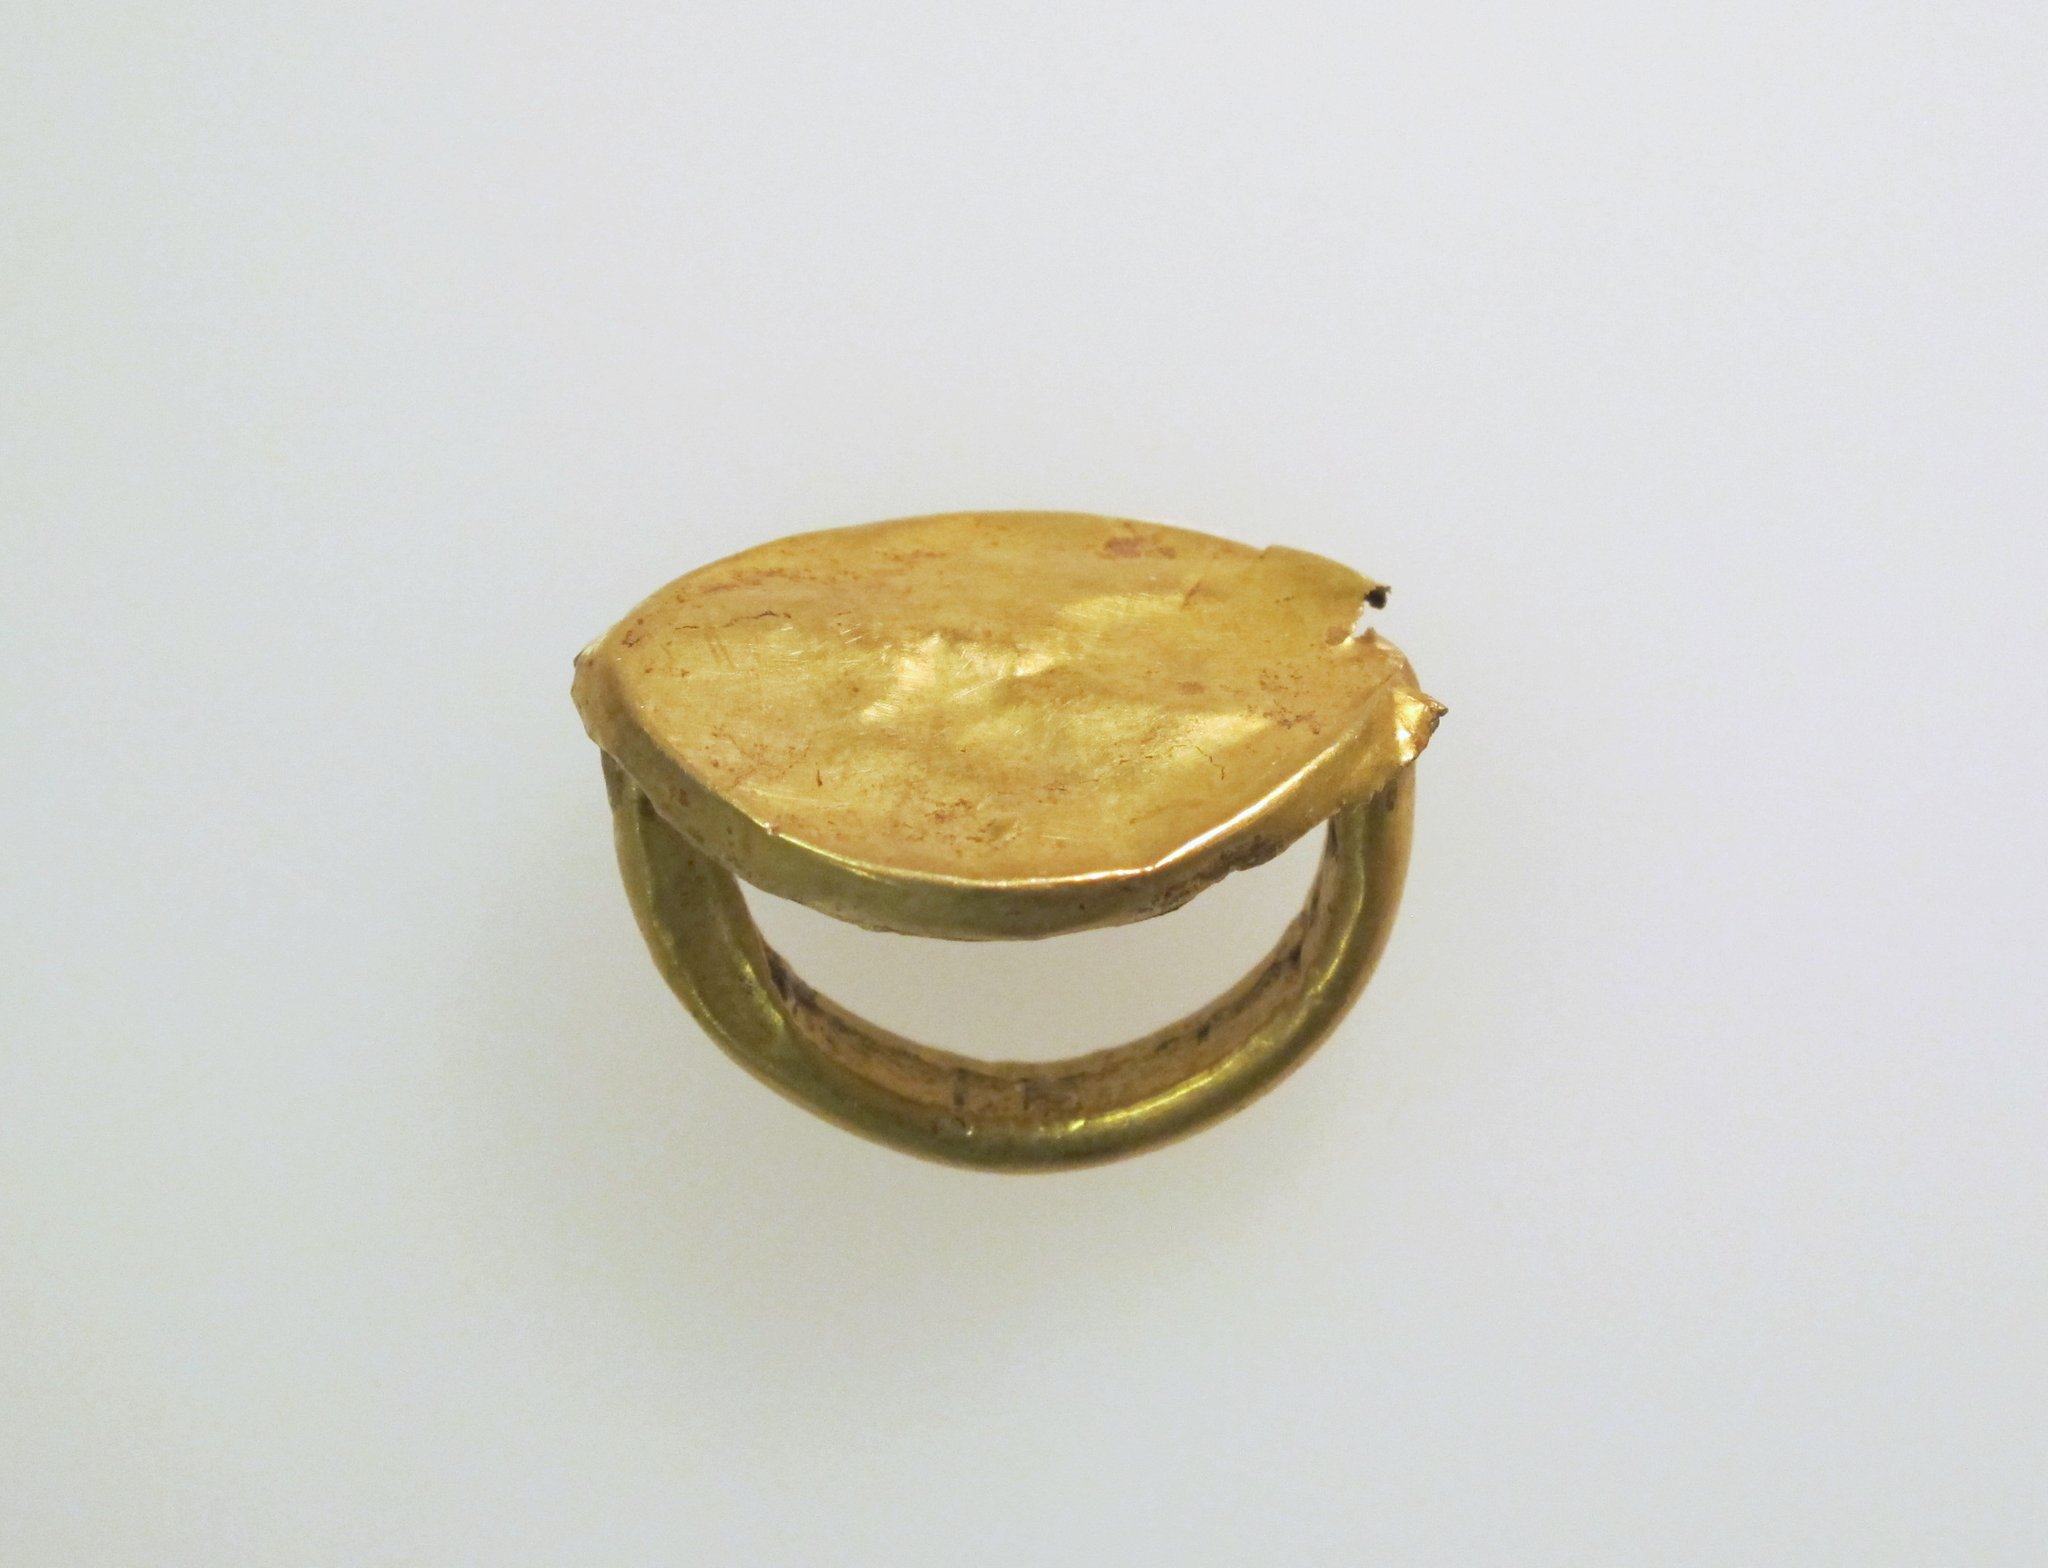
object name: ring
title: Gold ring with elliptical bezel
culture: etruscan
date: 500-401 BCE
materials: gold